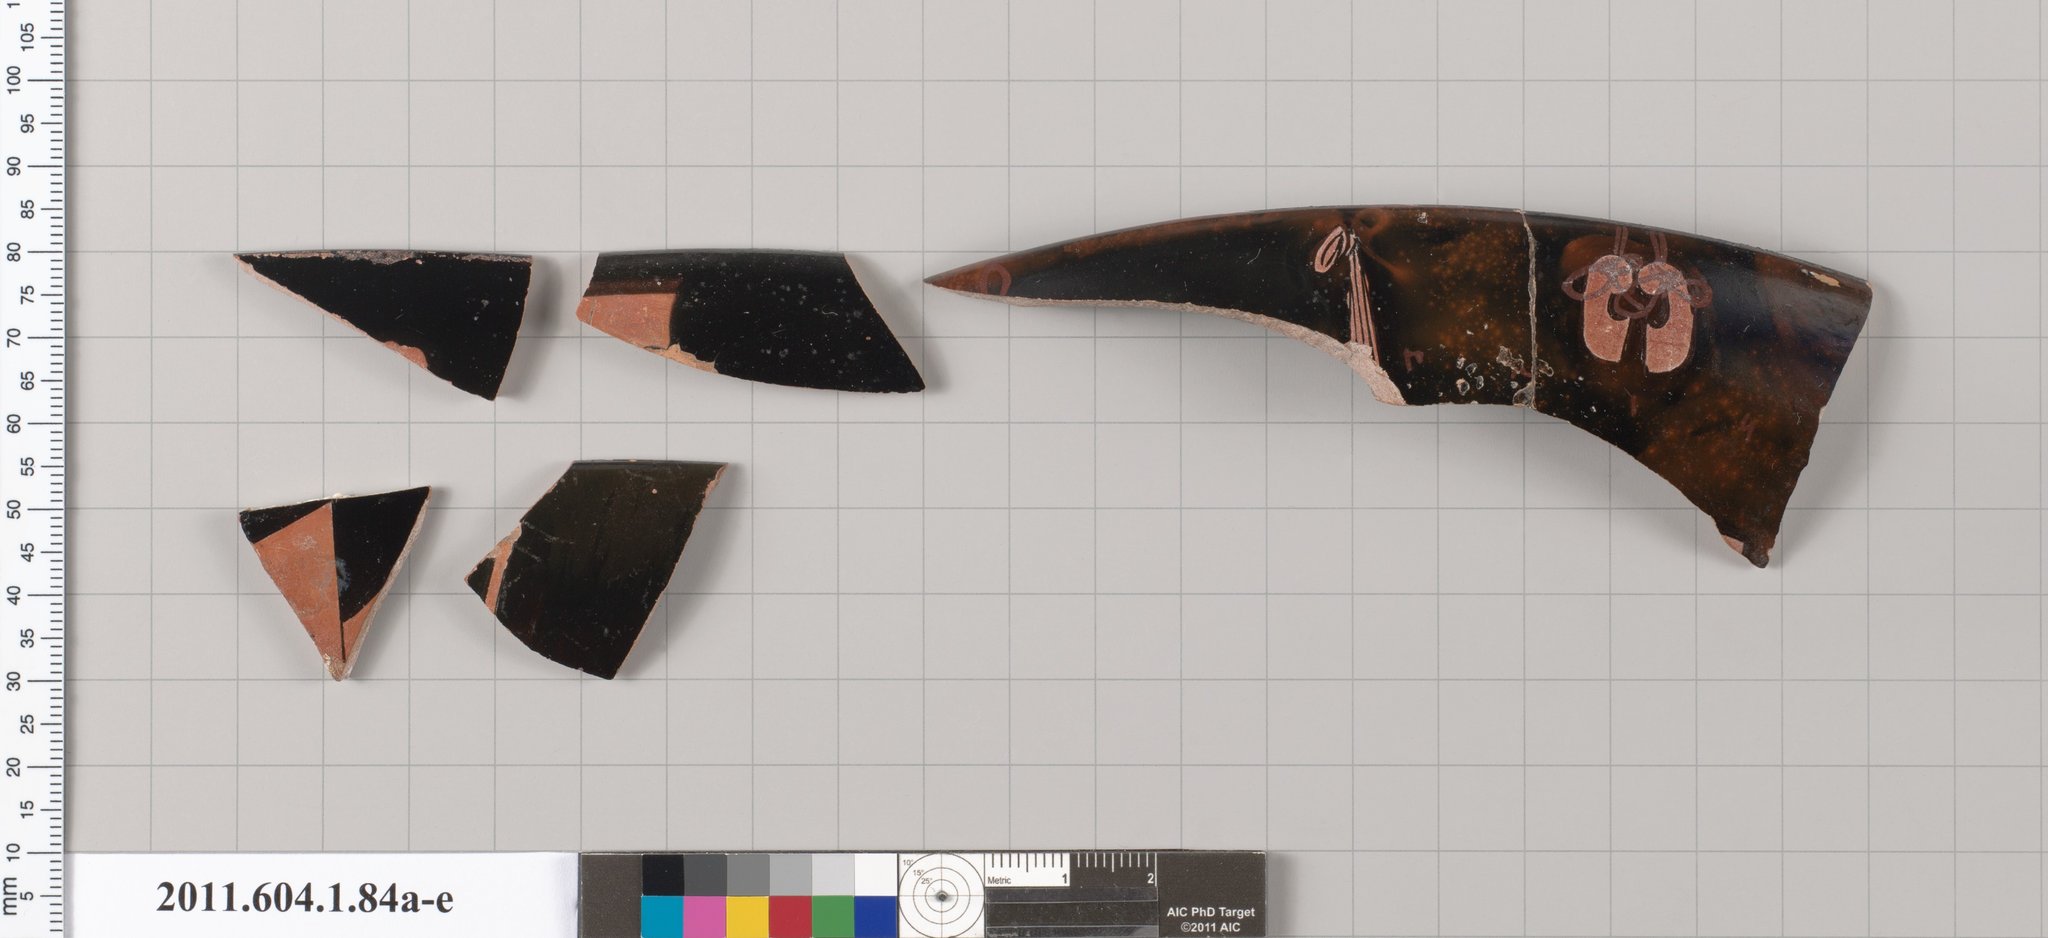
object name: kylix fragment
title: Terracotta fragments of a kylix (drinking cup)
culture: greek, attic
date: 490-480 BCE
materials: terracotta